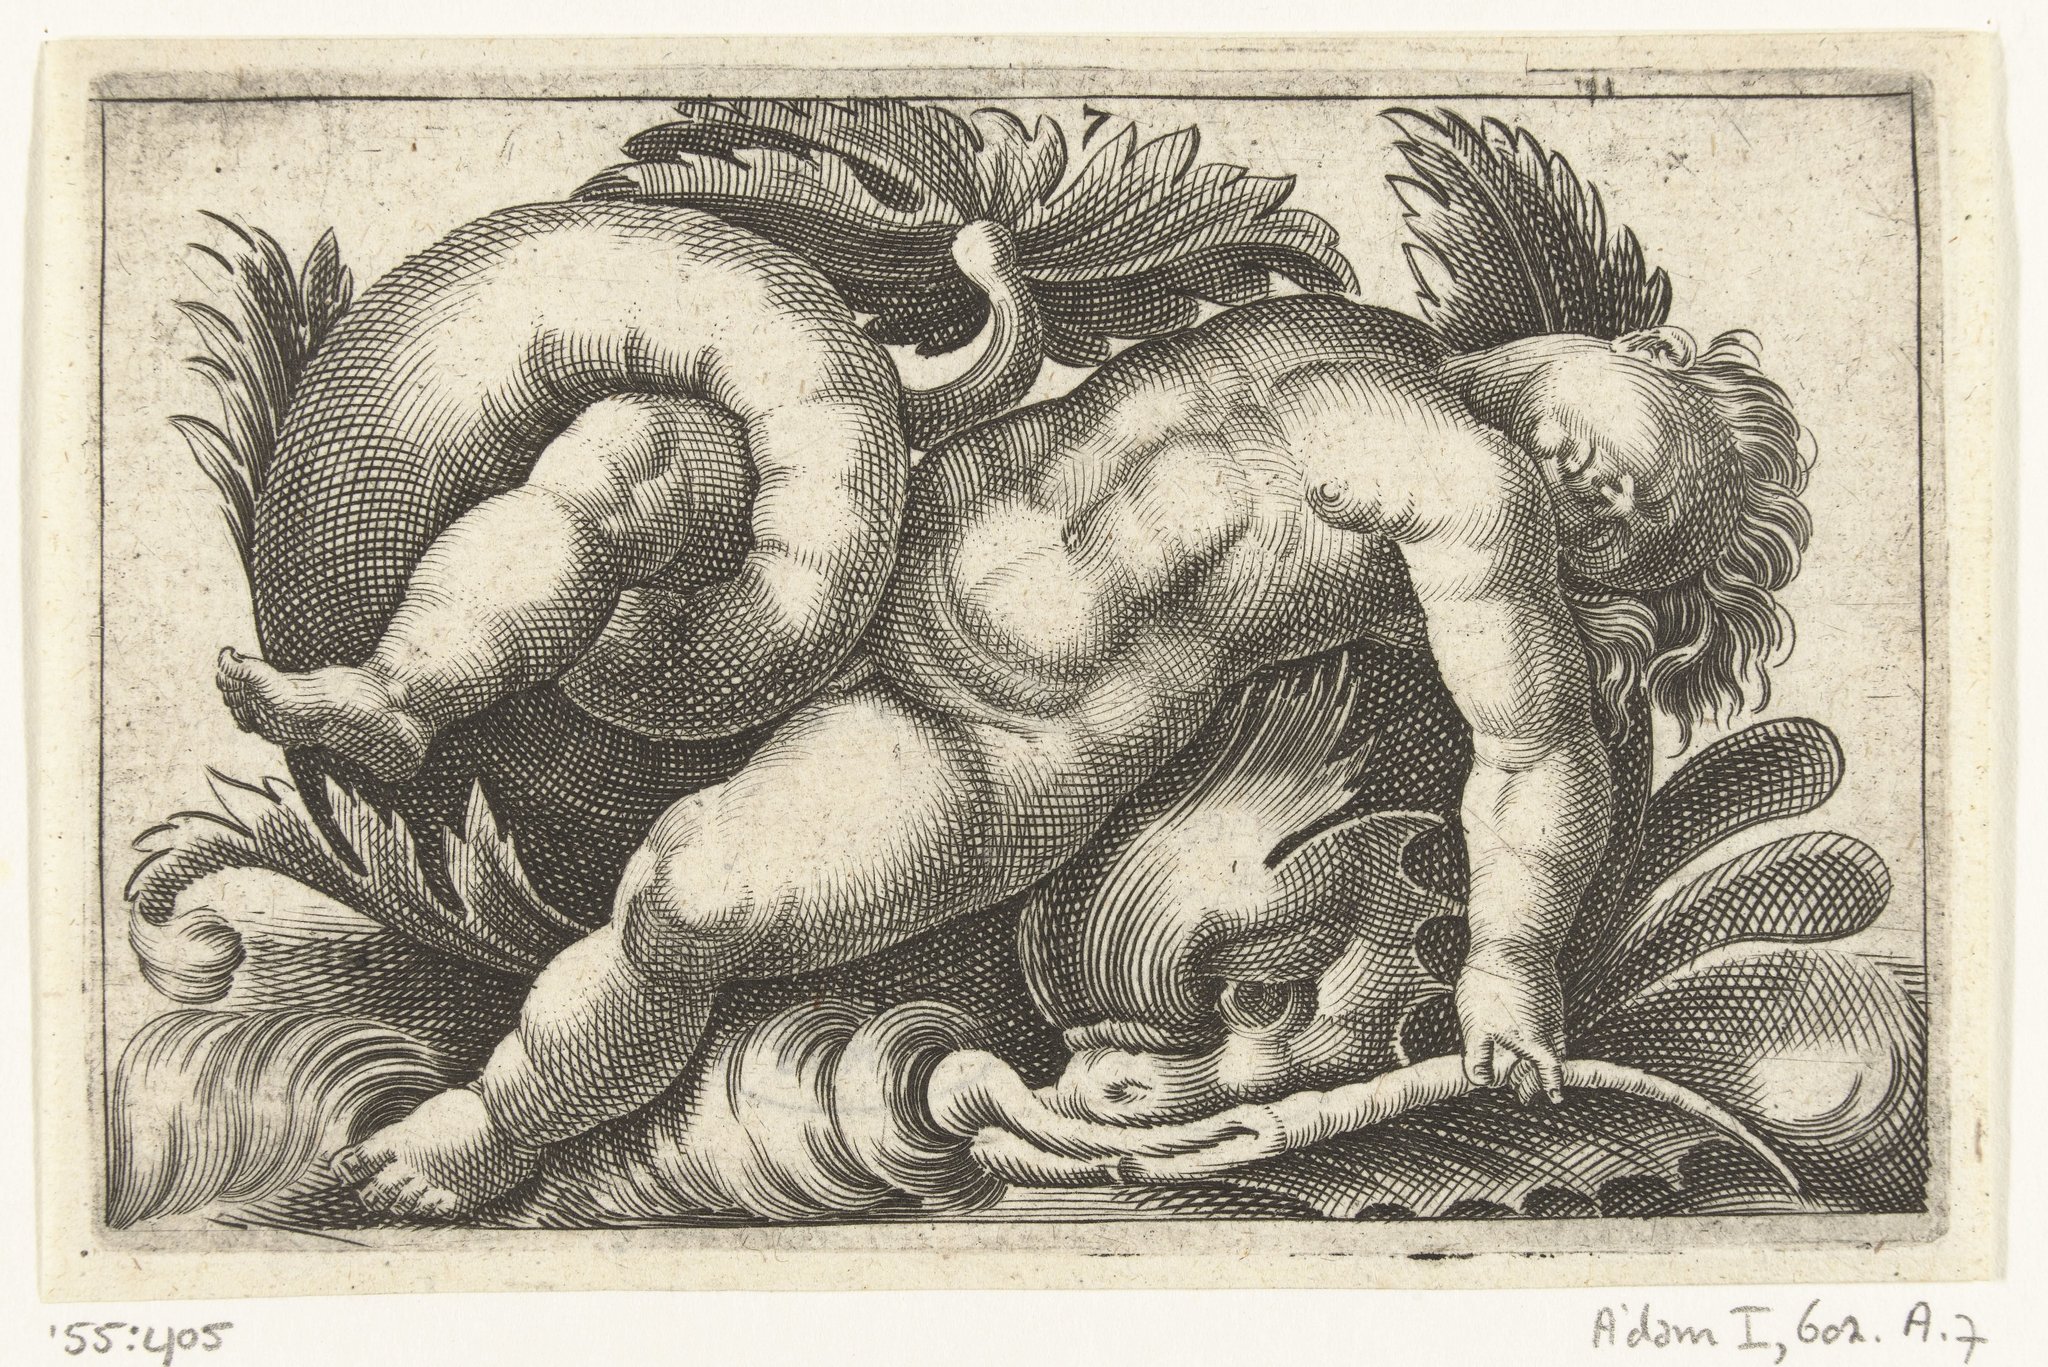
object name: print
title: Slapende putto op een dolfijn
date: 1605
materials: paper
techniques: engraving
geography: germany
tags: sleeping; unconsciousness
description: Tegenzijdige kopie naar een prent van Giovanni Andrea Maglioli.